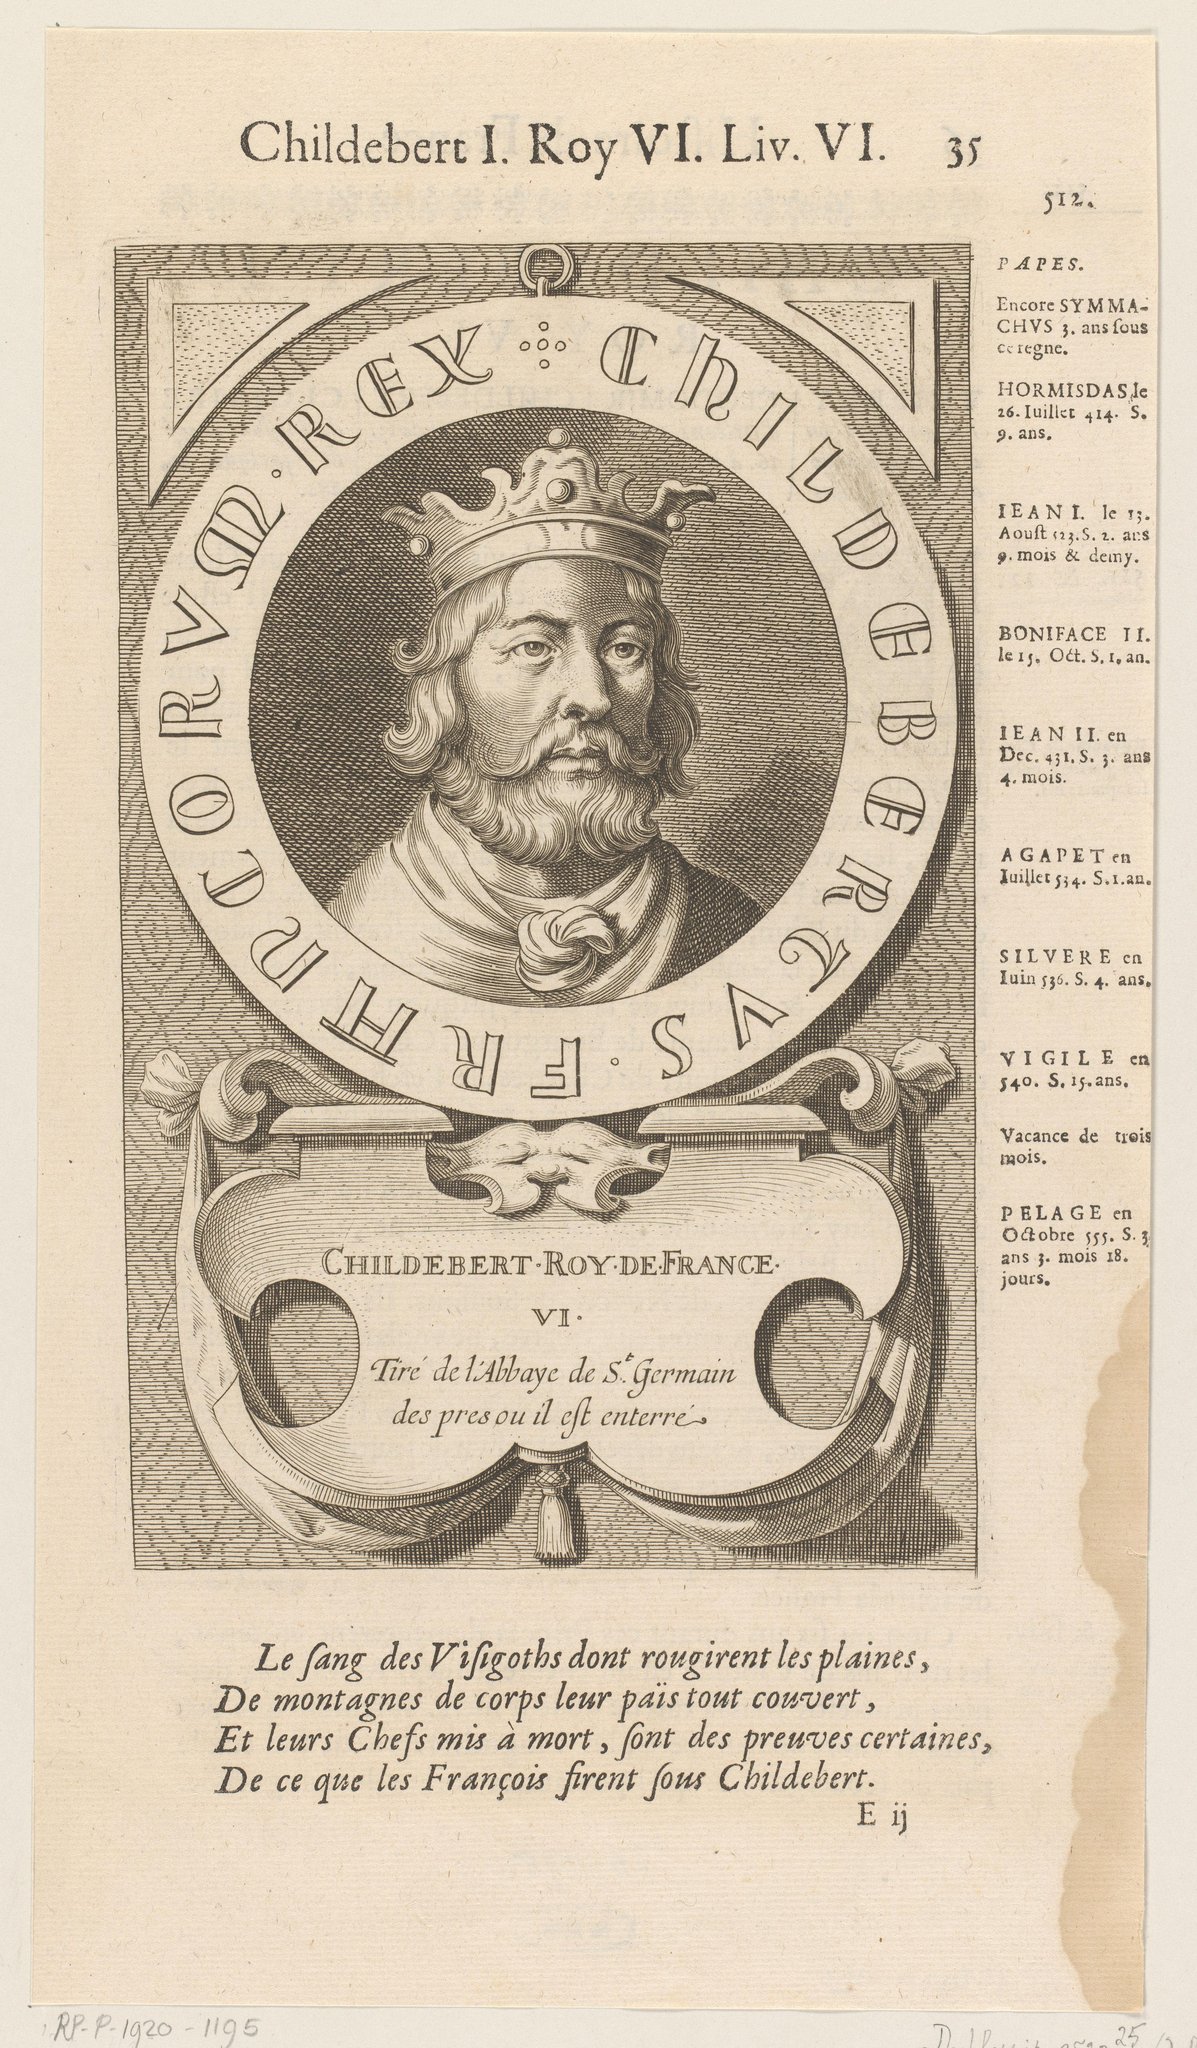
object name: print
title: Childebert I, koning der Franken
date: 1635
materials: paper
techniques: engraving, letterpress printing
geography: paris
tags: historical persons, ruler, sovereign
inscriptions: collector's mark: Lugt 2228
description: Prent uit: Eudes de Mézeray, François. Histoire de France, depuis Faramond jusqu’au regne de Louis le Juste (...). 3 dln. Parijs: Denis Thierry, Jean Guignard en Claude Barbin, 1635, dl. 1. Prent waarschijnlijk voor het eerst verschenen in: Bie, Jacques de. Les vrais portraits des rois de France (...). Parijs: Jacques de Bie en Pierre Rocolet, 1634. Prent ook gebruikt in latere publicaties.